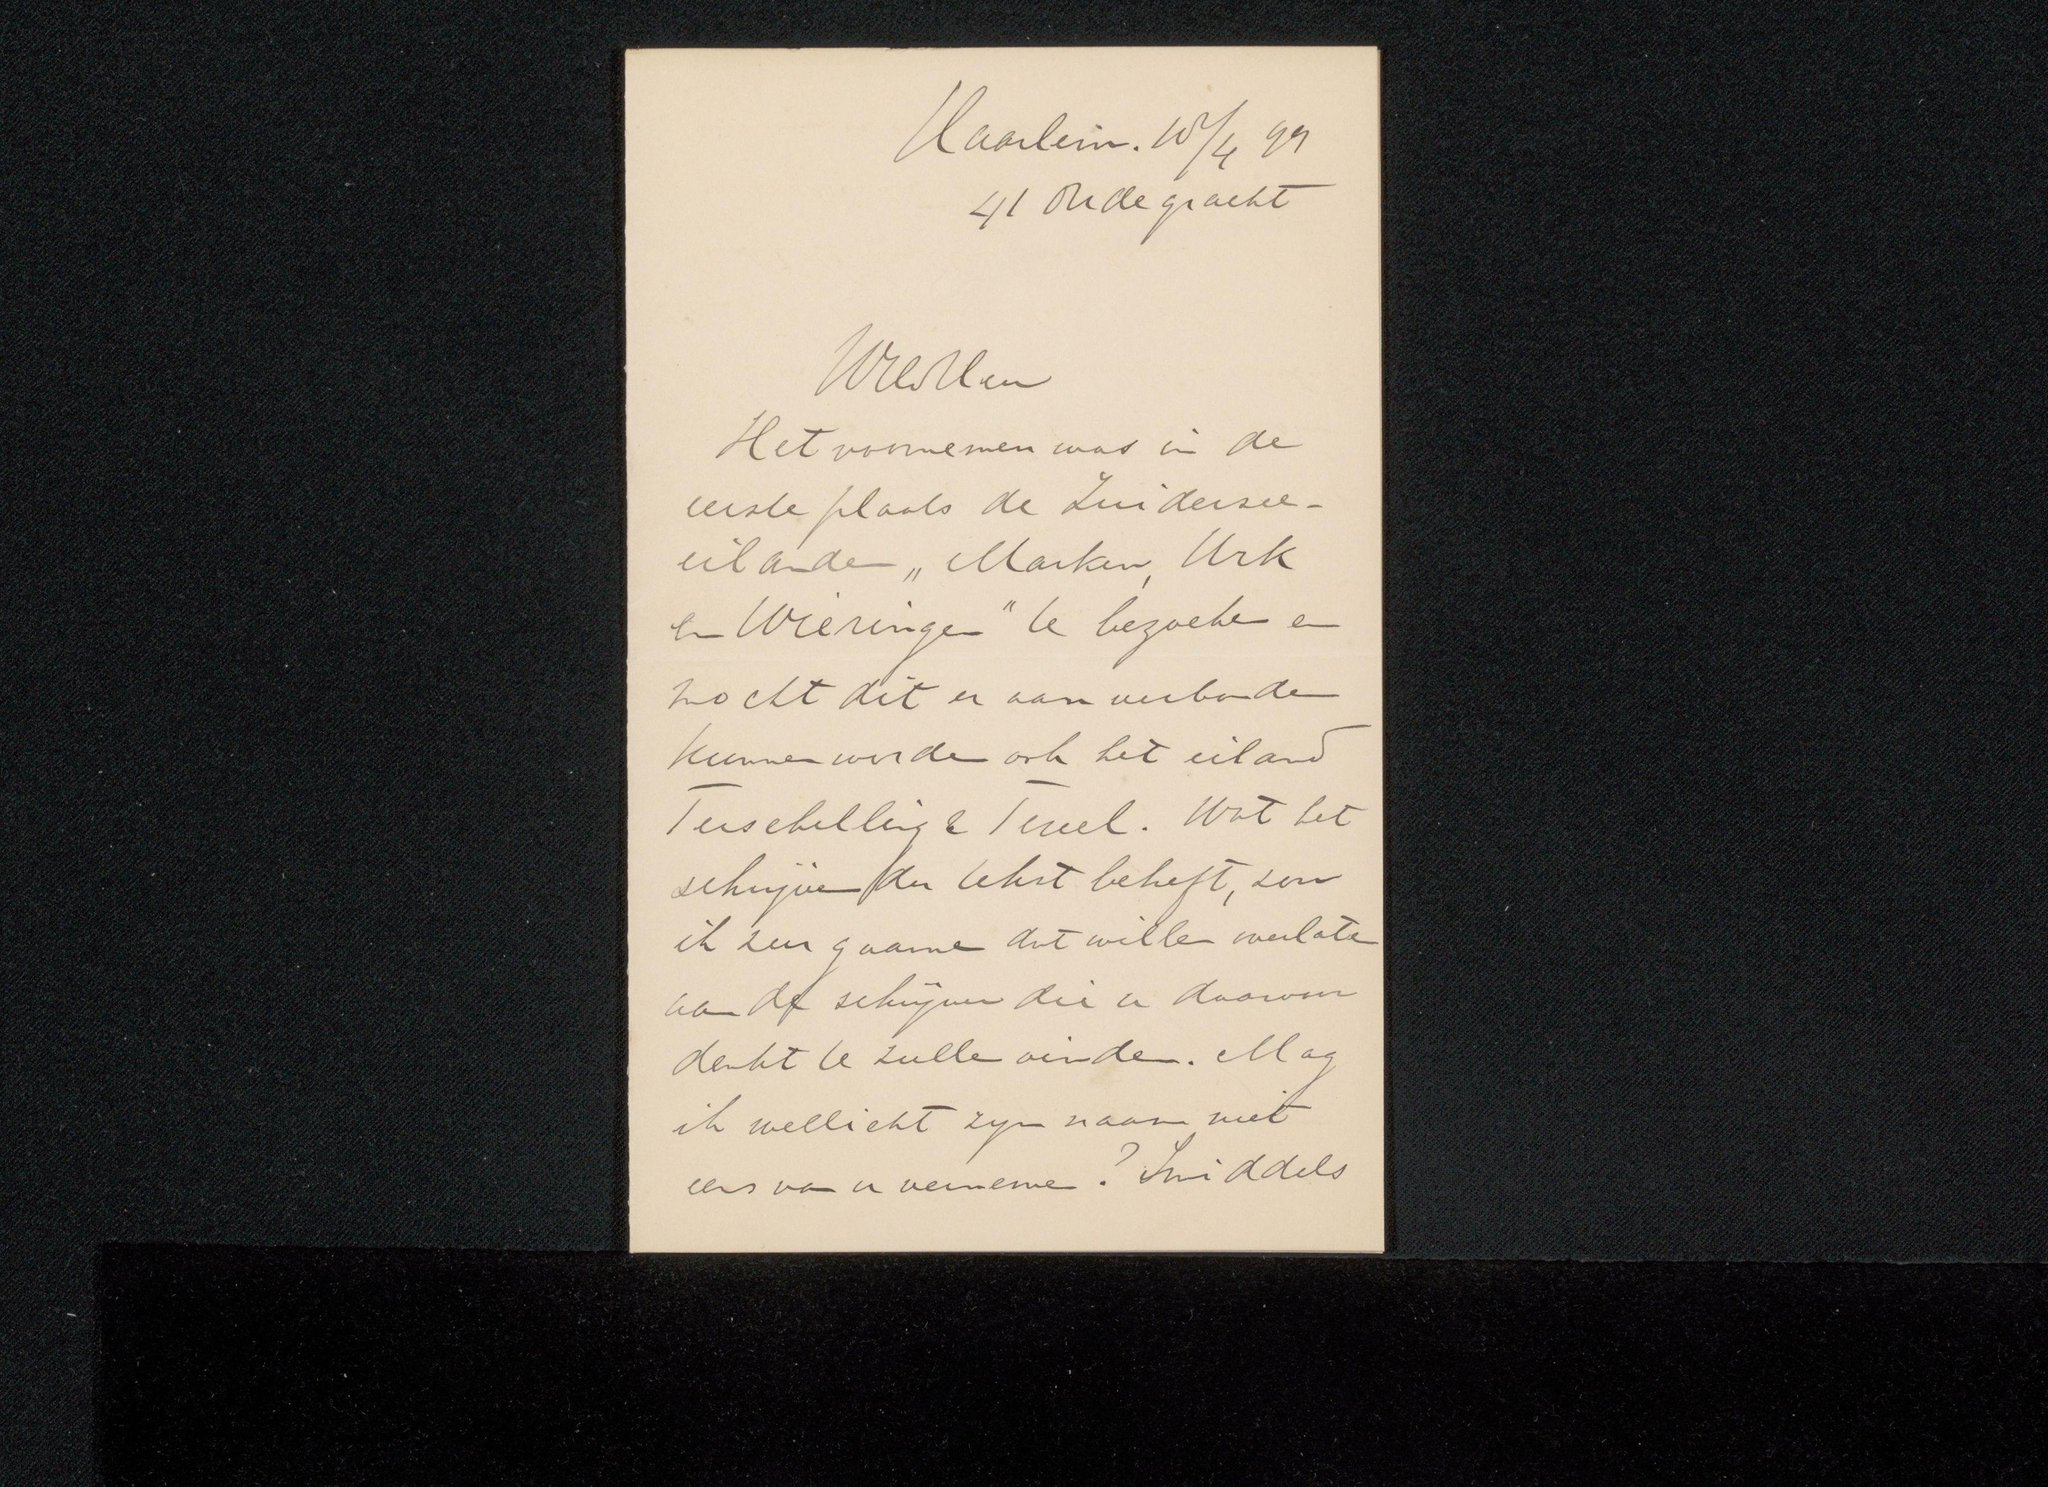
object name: letter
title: Brief aan Philip Zilcken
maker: jacobus gerardus veldheer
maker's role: draughtsman, print maker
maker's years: 1866-1954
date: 1899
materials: ink, paper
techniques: pen, writing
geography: haarlem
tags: painter, draughtsman, philip zilcken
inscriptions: collector's mark: ‘RPK’, watermark